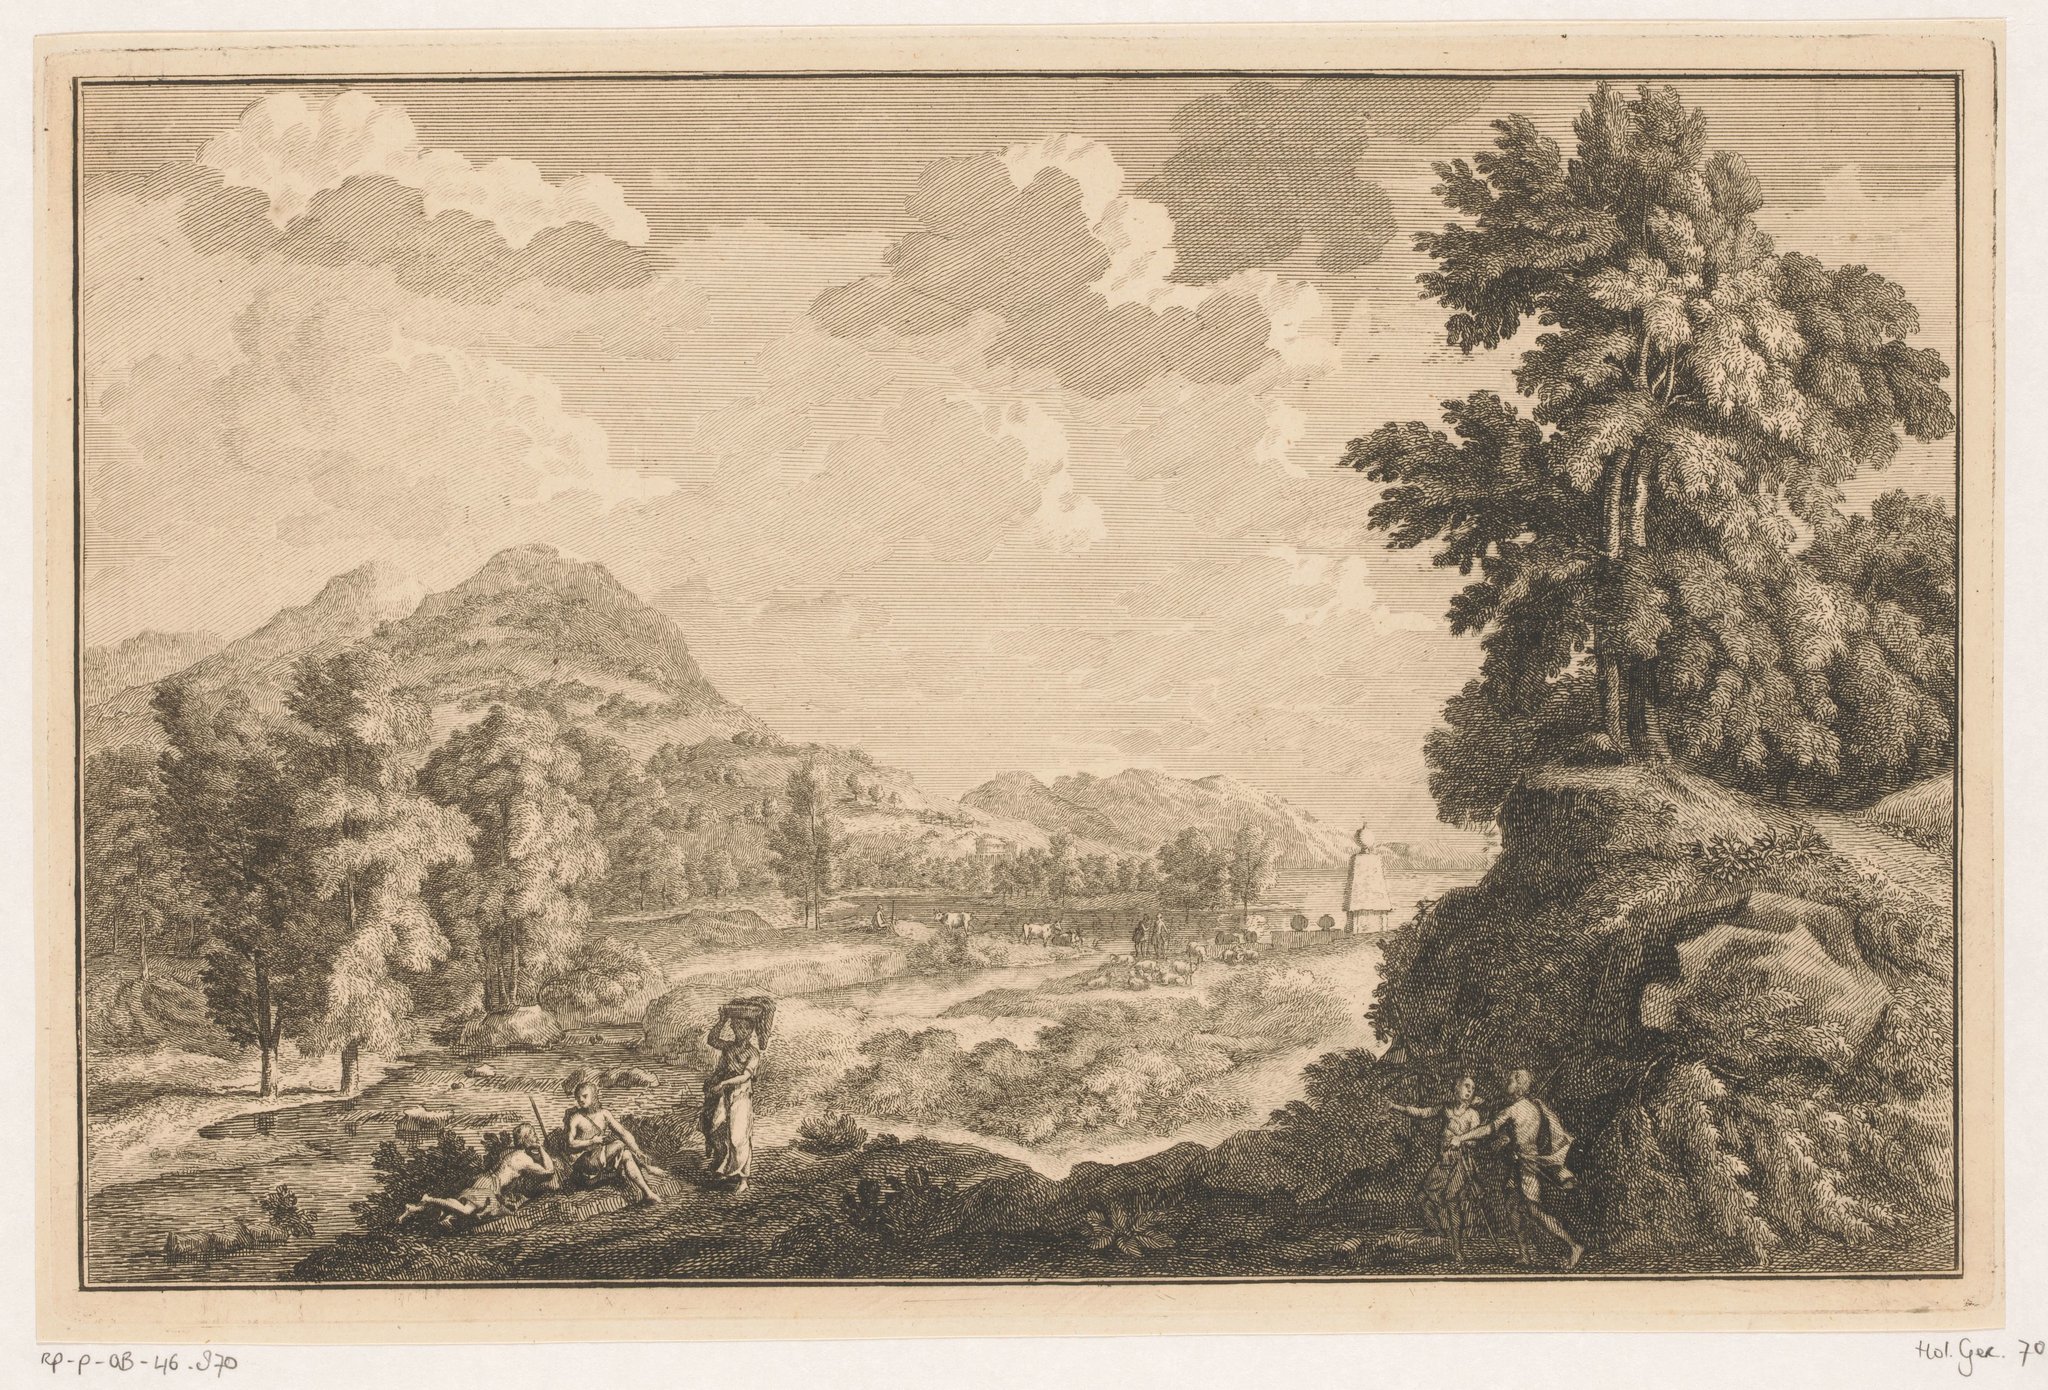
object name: print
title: Arcadisch rivierlandschap met herders en vrouw met een wasmand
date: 1710-1747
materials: paper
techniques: etching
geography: amsterdam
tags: herding, herdsman, herdswoman, shepherd, shepherdess, cowherd, etc., cattle, landscapes with waters, waterscapes, seascapes (in the temperate zone), carrying something in basket, bag, rucksack, etc.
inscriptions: collector's mark: Lugt 240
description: Arcadisch rivierlandschap met op de voorgrond herders en een vrouw met wasmand op het hoofd. In de verte herders en een kudde dieren. De prent maakt mogelijk deel uit van een 40-delige serie prenten met voorstellingen van Italiaanse en Duitse landschappen.